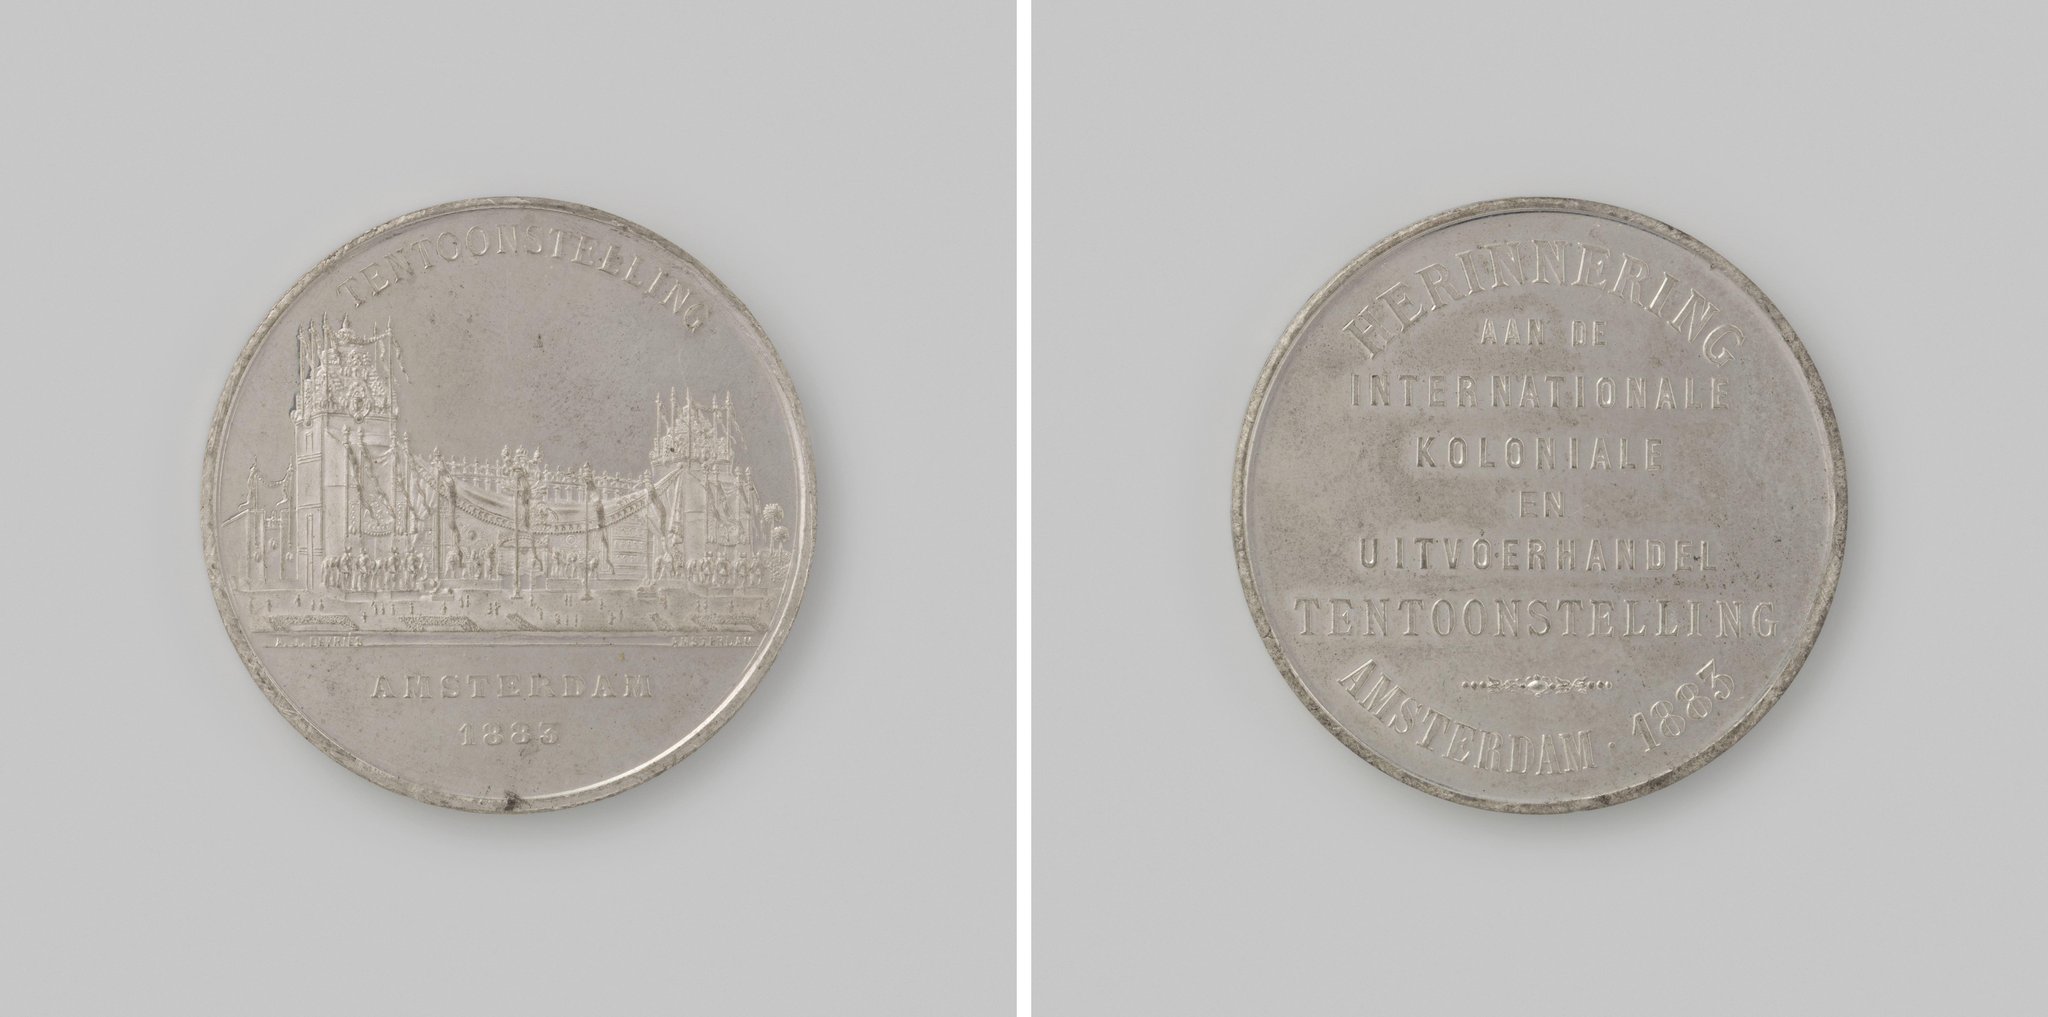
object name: history medal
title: Herinnering aan de Internationale Koloniale en Uitvoerhandel-Tentoonstelling te Amsterdam 1883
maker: alexander isaac de vries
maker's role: graveur, koopman, medailleur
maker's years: 1820-1901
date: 1883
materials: tin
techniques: striking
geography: amsterdam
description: Tinnen penning, op de voorzijde het aanzicht van het tentoonstellingsgebouw, met omschrift bovenaan en afsnedetekst, op de keerzijde acht regels tekst.